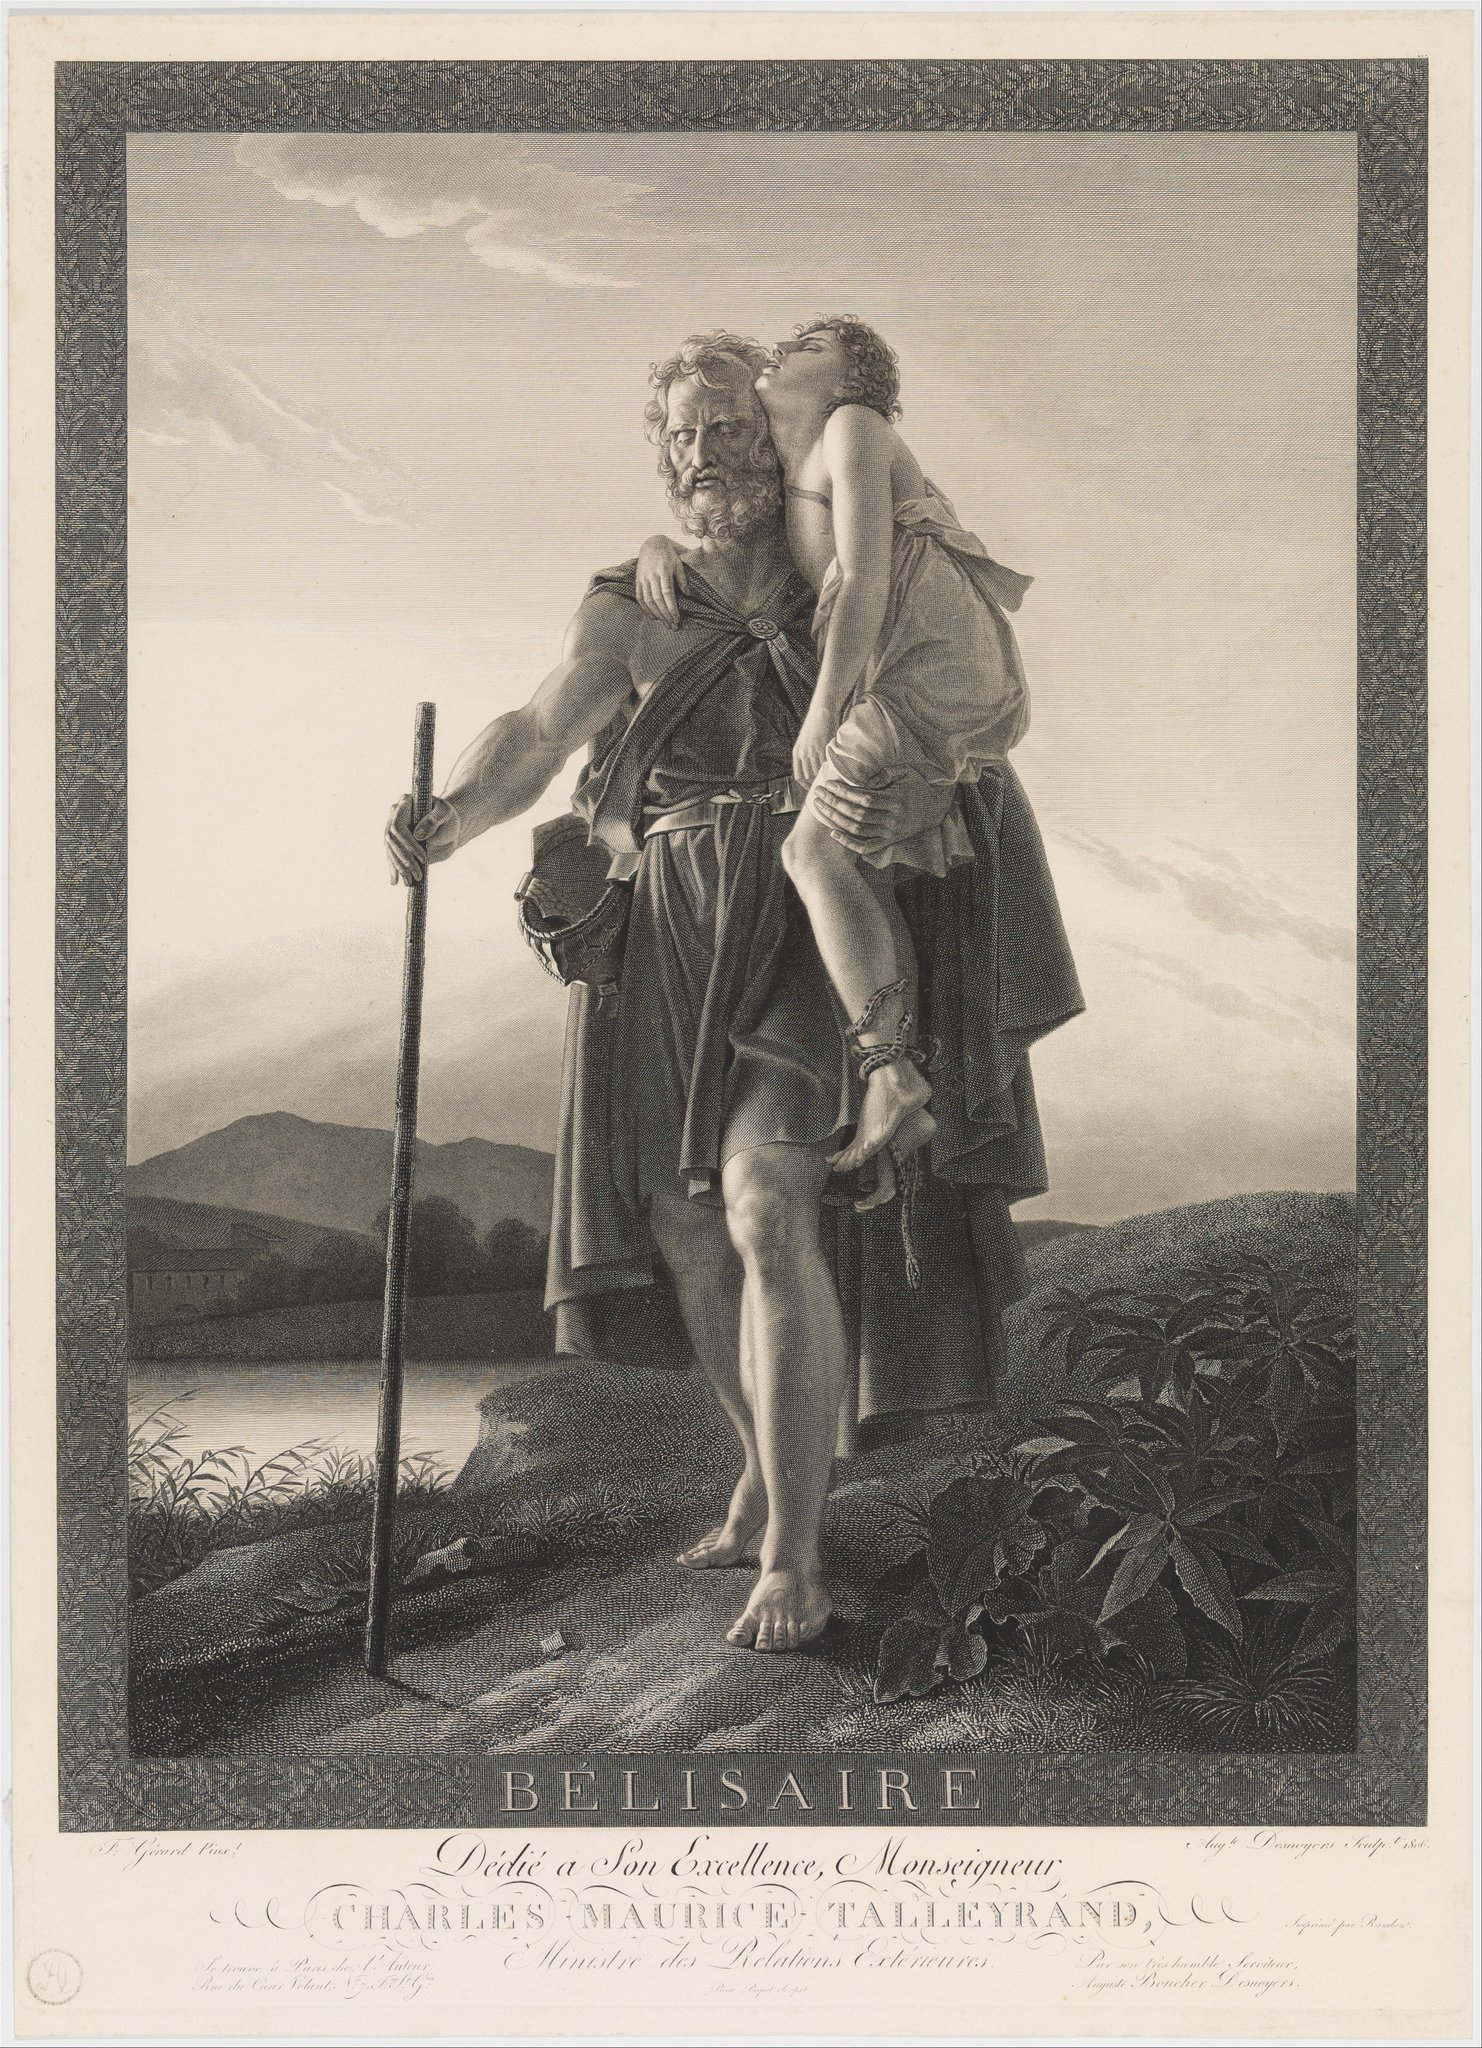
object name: print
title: Belisarius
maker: auguste gaspard louis boucher desnoyers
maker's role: artist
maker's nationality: french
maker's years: 1779-1857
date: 1806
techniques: engraving, etching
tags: boys,men,generals